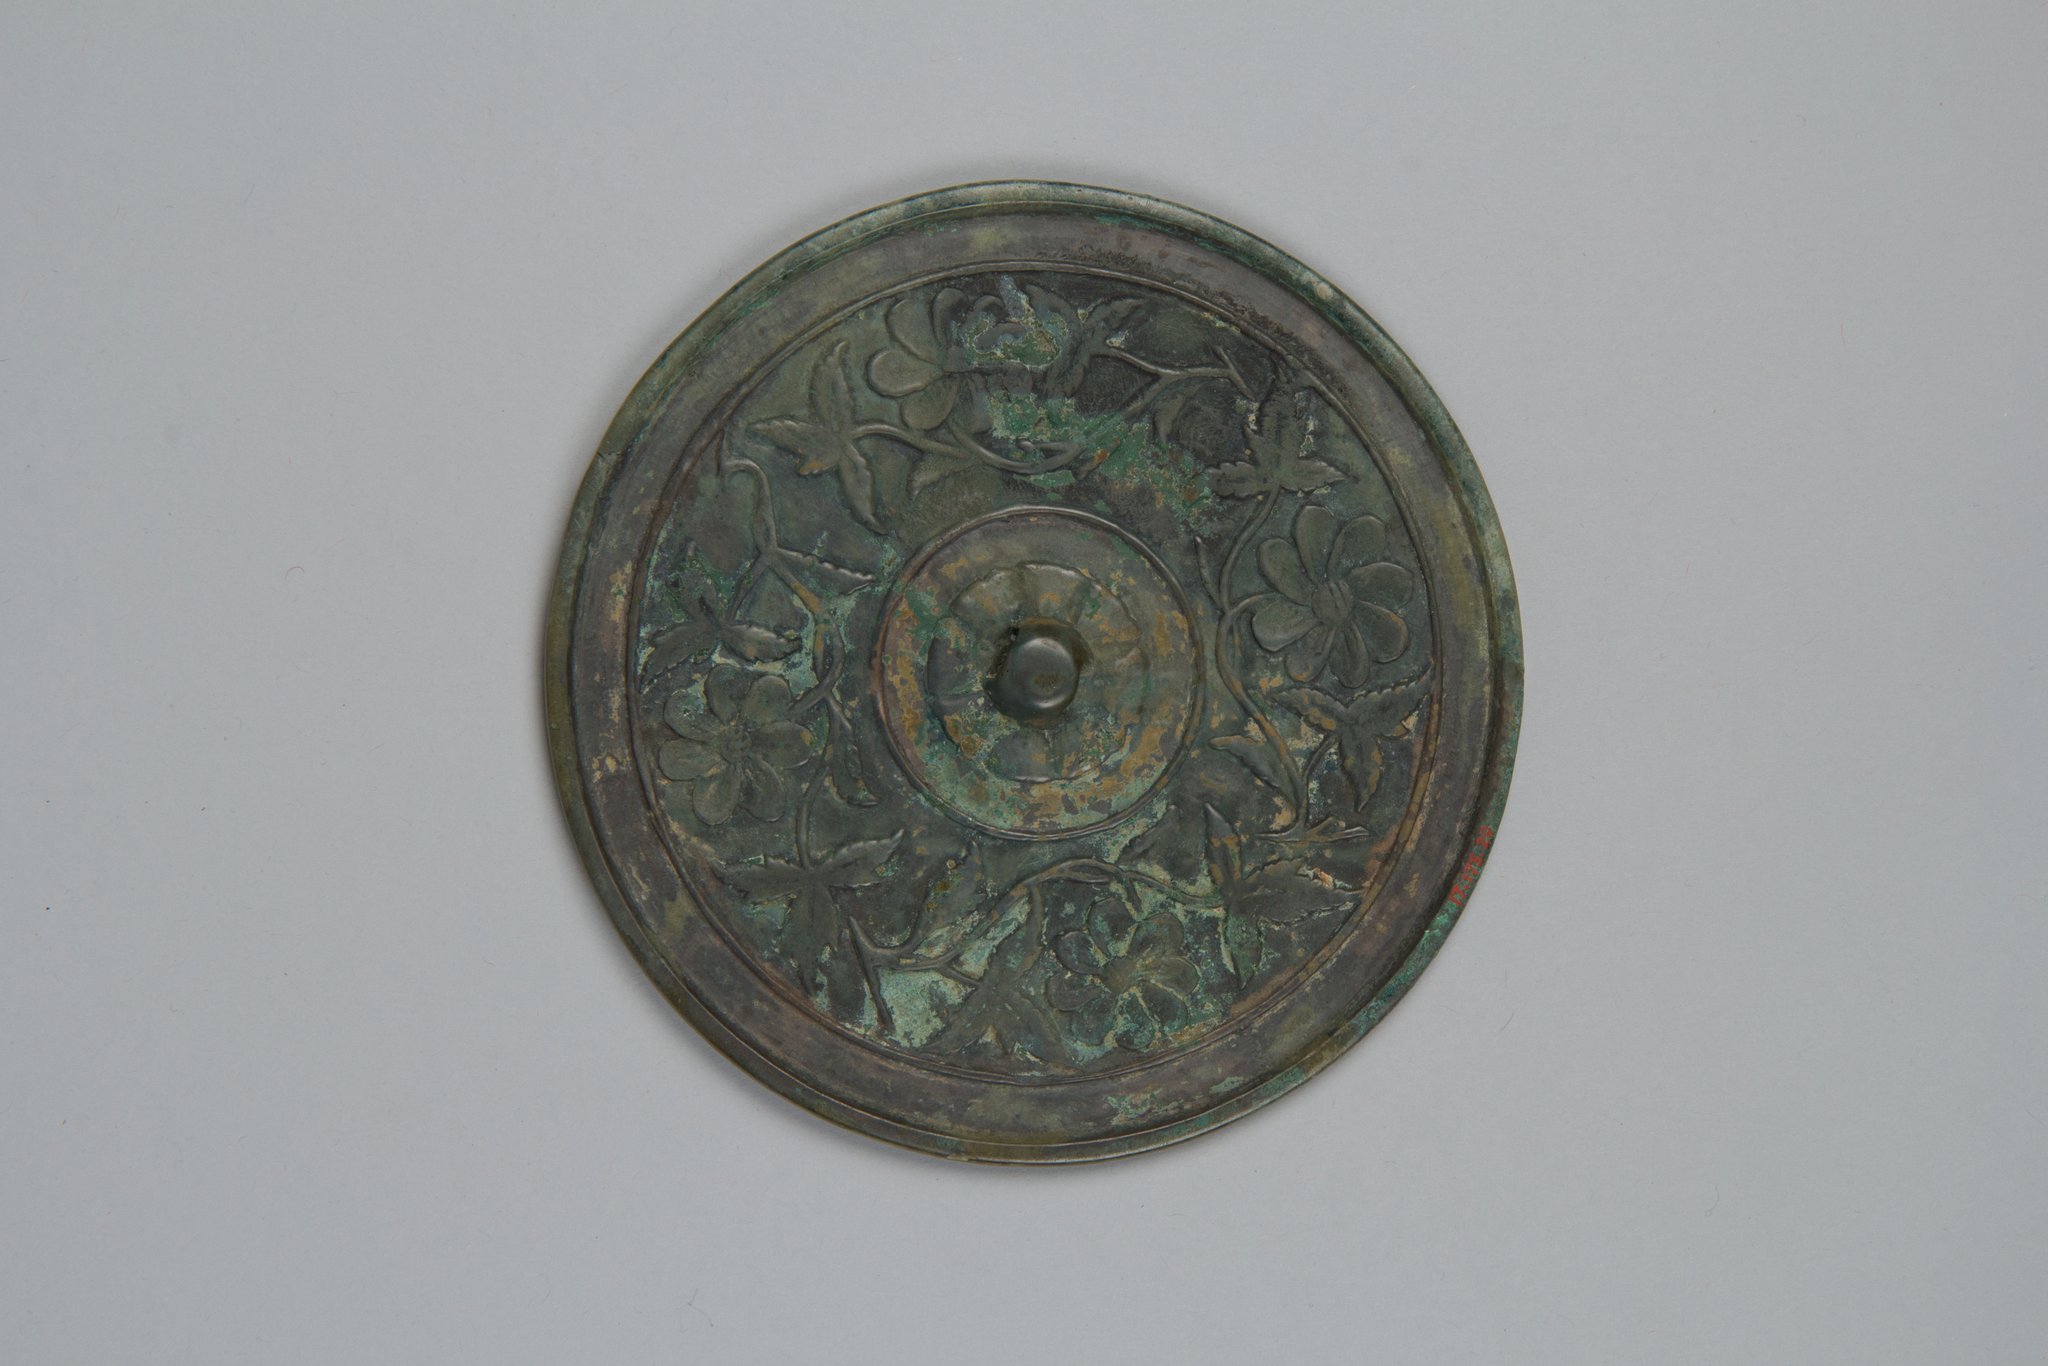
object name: mirror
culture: korean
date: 918-1392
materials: bronze